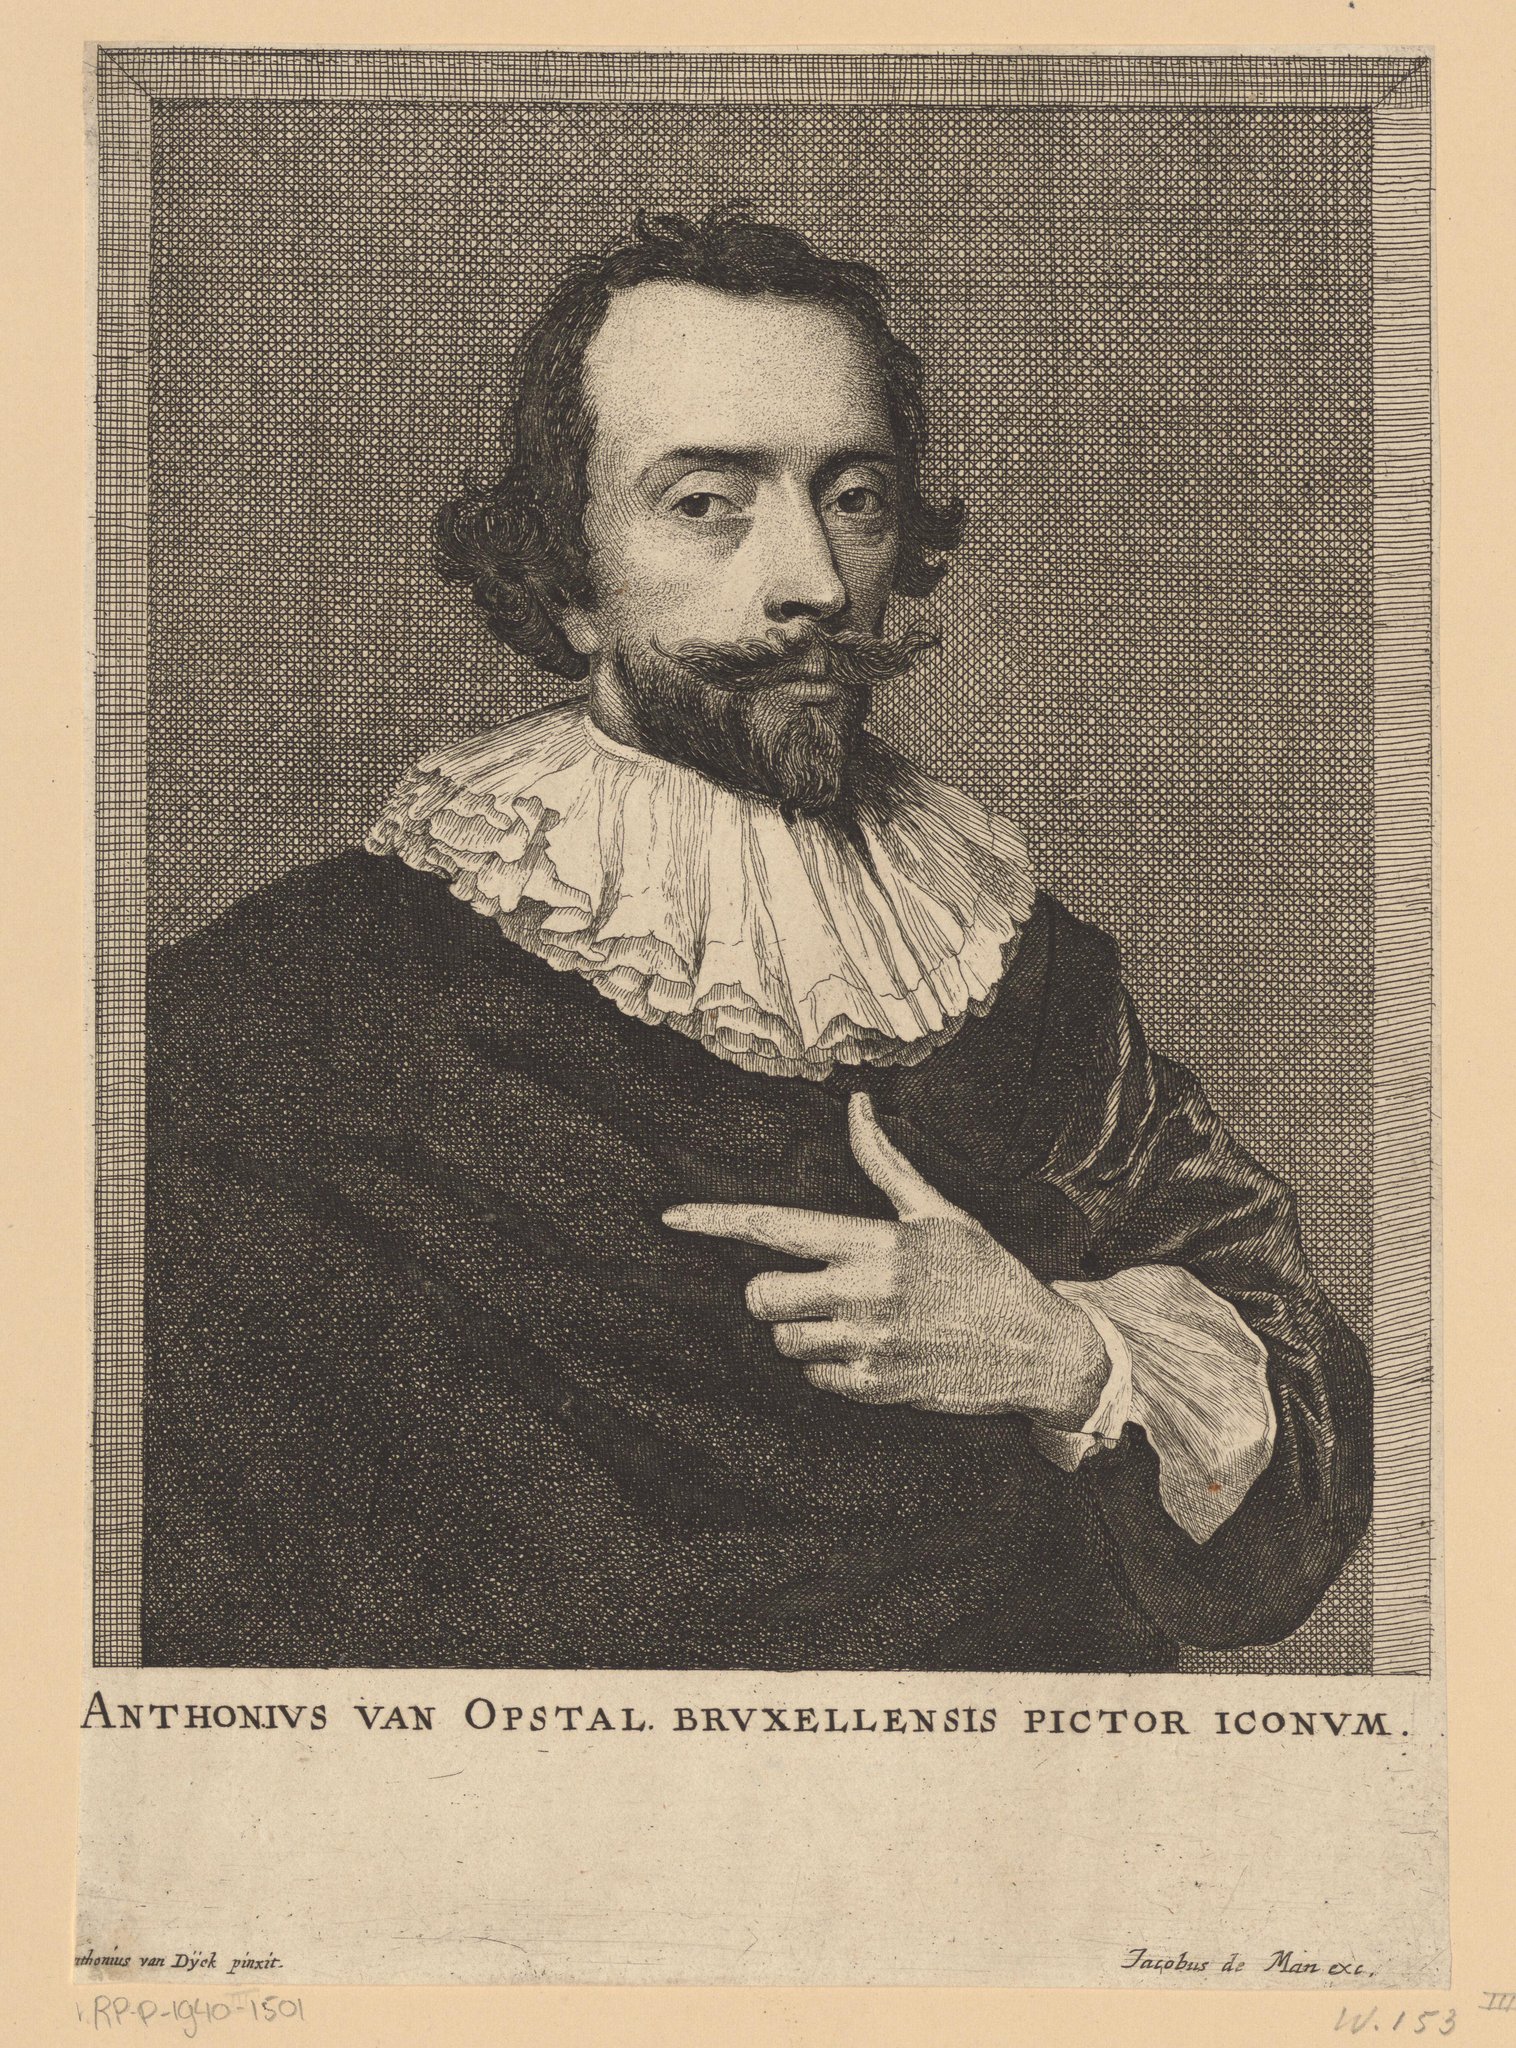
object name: print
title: Portret van Anton van Opstal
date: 1676-1719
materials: paper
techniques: etching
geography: antwerp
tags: antwerp, painter, anton van opstal, historical persons, portrait, self-portrait of painter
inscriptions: collector's mark: Lugt 2166, collector's mark: Lugt 2228, collector's mark: Lugt 2760